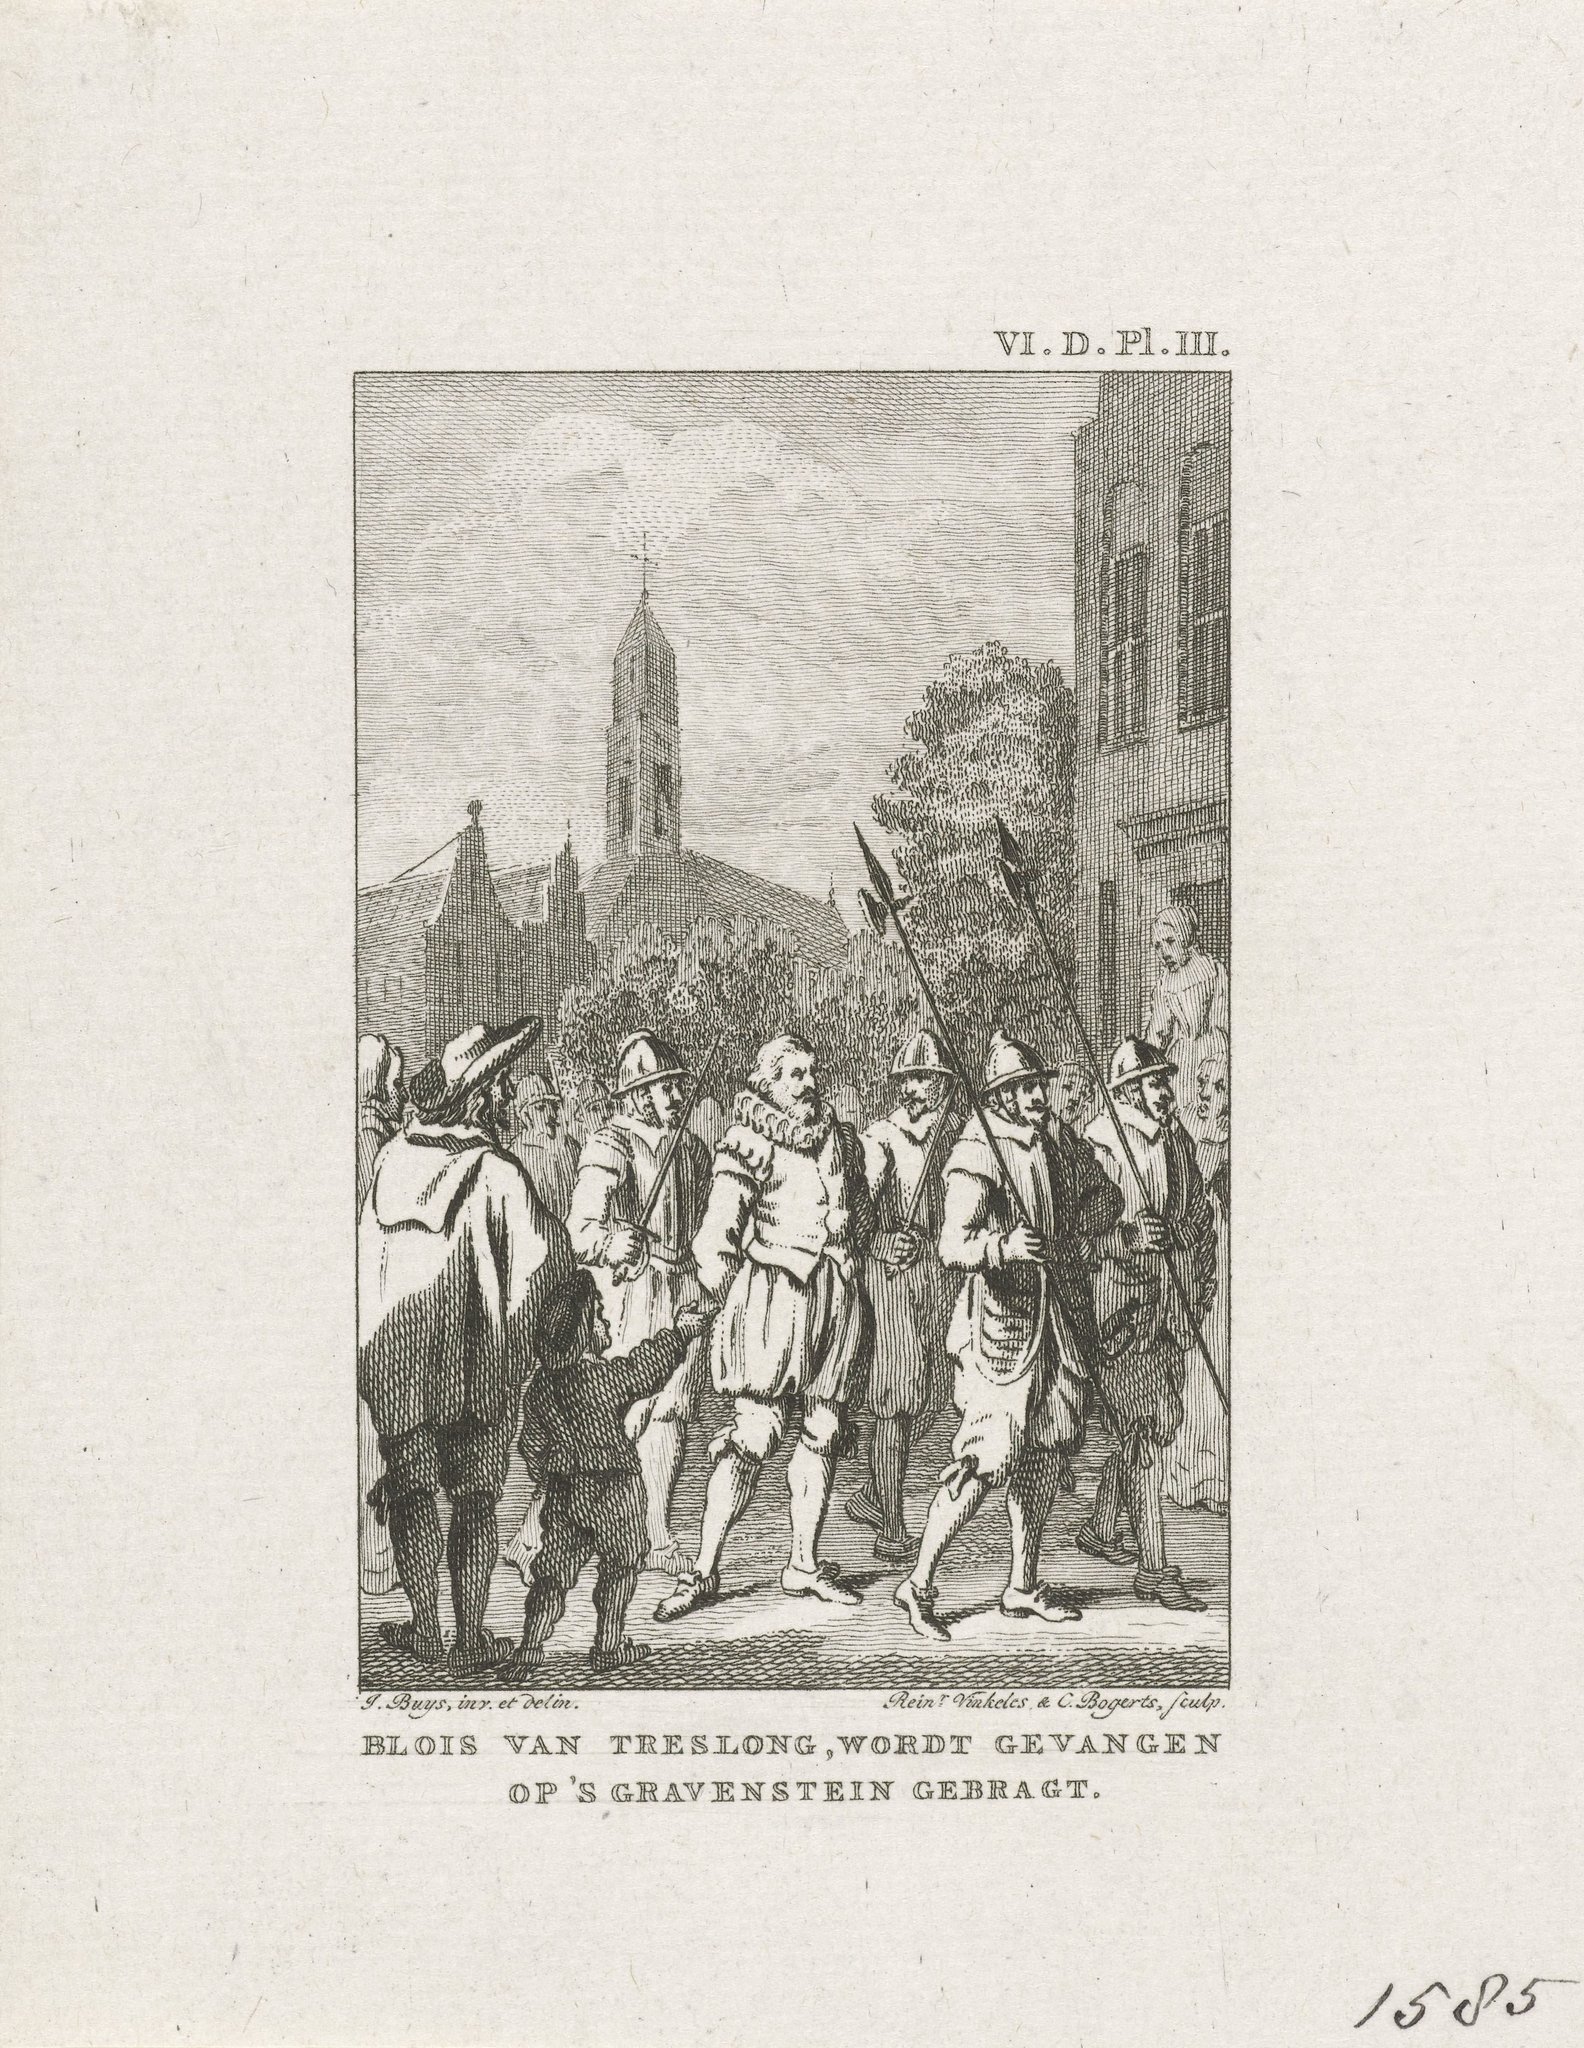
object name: print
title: Blois van Treslong, wordt gevangen op 's Gravenstein gebragt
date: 1780-1795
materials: paper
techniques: etching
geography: netherlands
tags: brielle, imprisonment, middelburg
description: Admiraal Blois van Treslong, beticht van corruptie en insubordinatie, wordt gevangengenomen en onder militaire escorte naar het Gravensteen te Middelburg gebracht, 27 februari 1585.